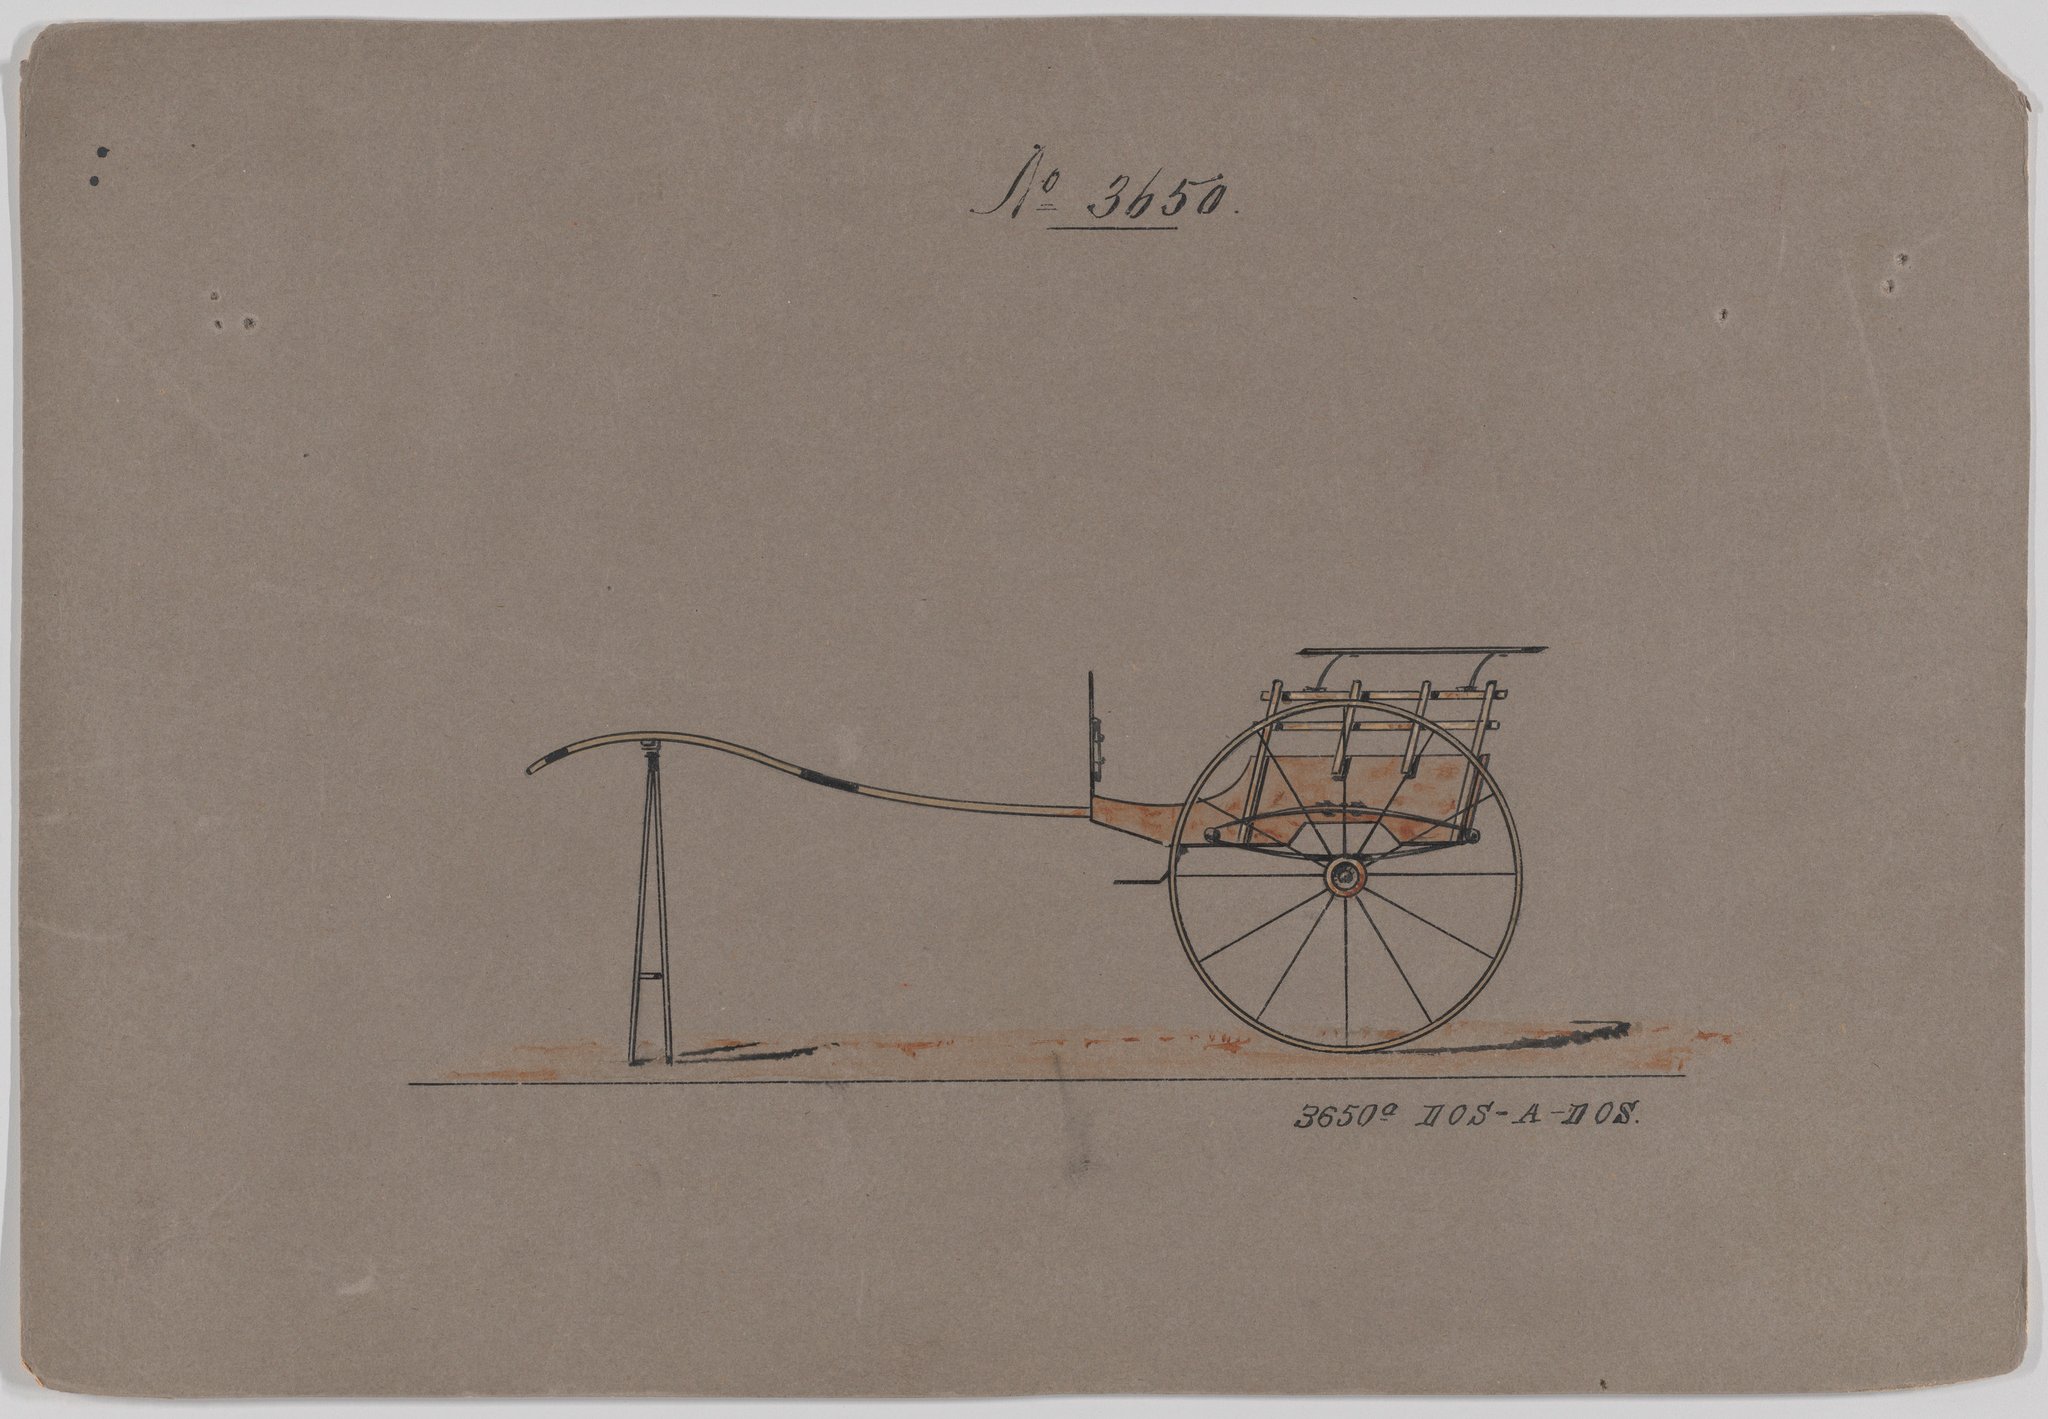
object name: drawing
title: Slat Side Pony Cart #3650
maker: brewster & co.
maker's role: manufacturer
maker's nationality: american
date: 1881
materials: gouache, gum arabic, ink, watercolor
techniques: pen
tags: carriages